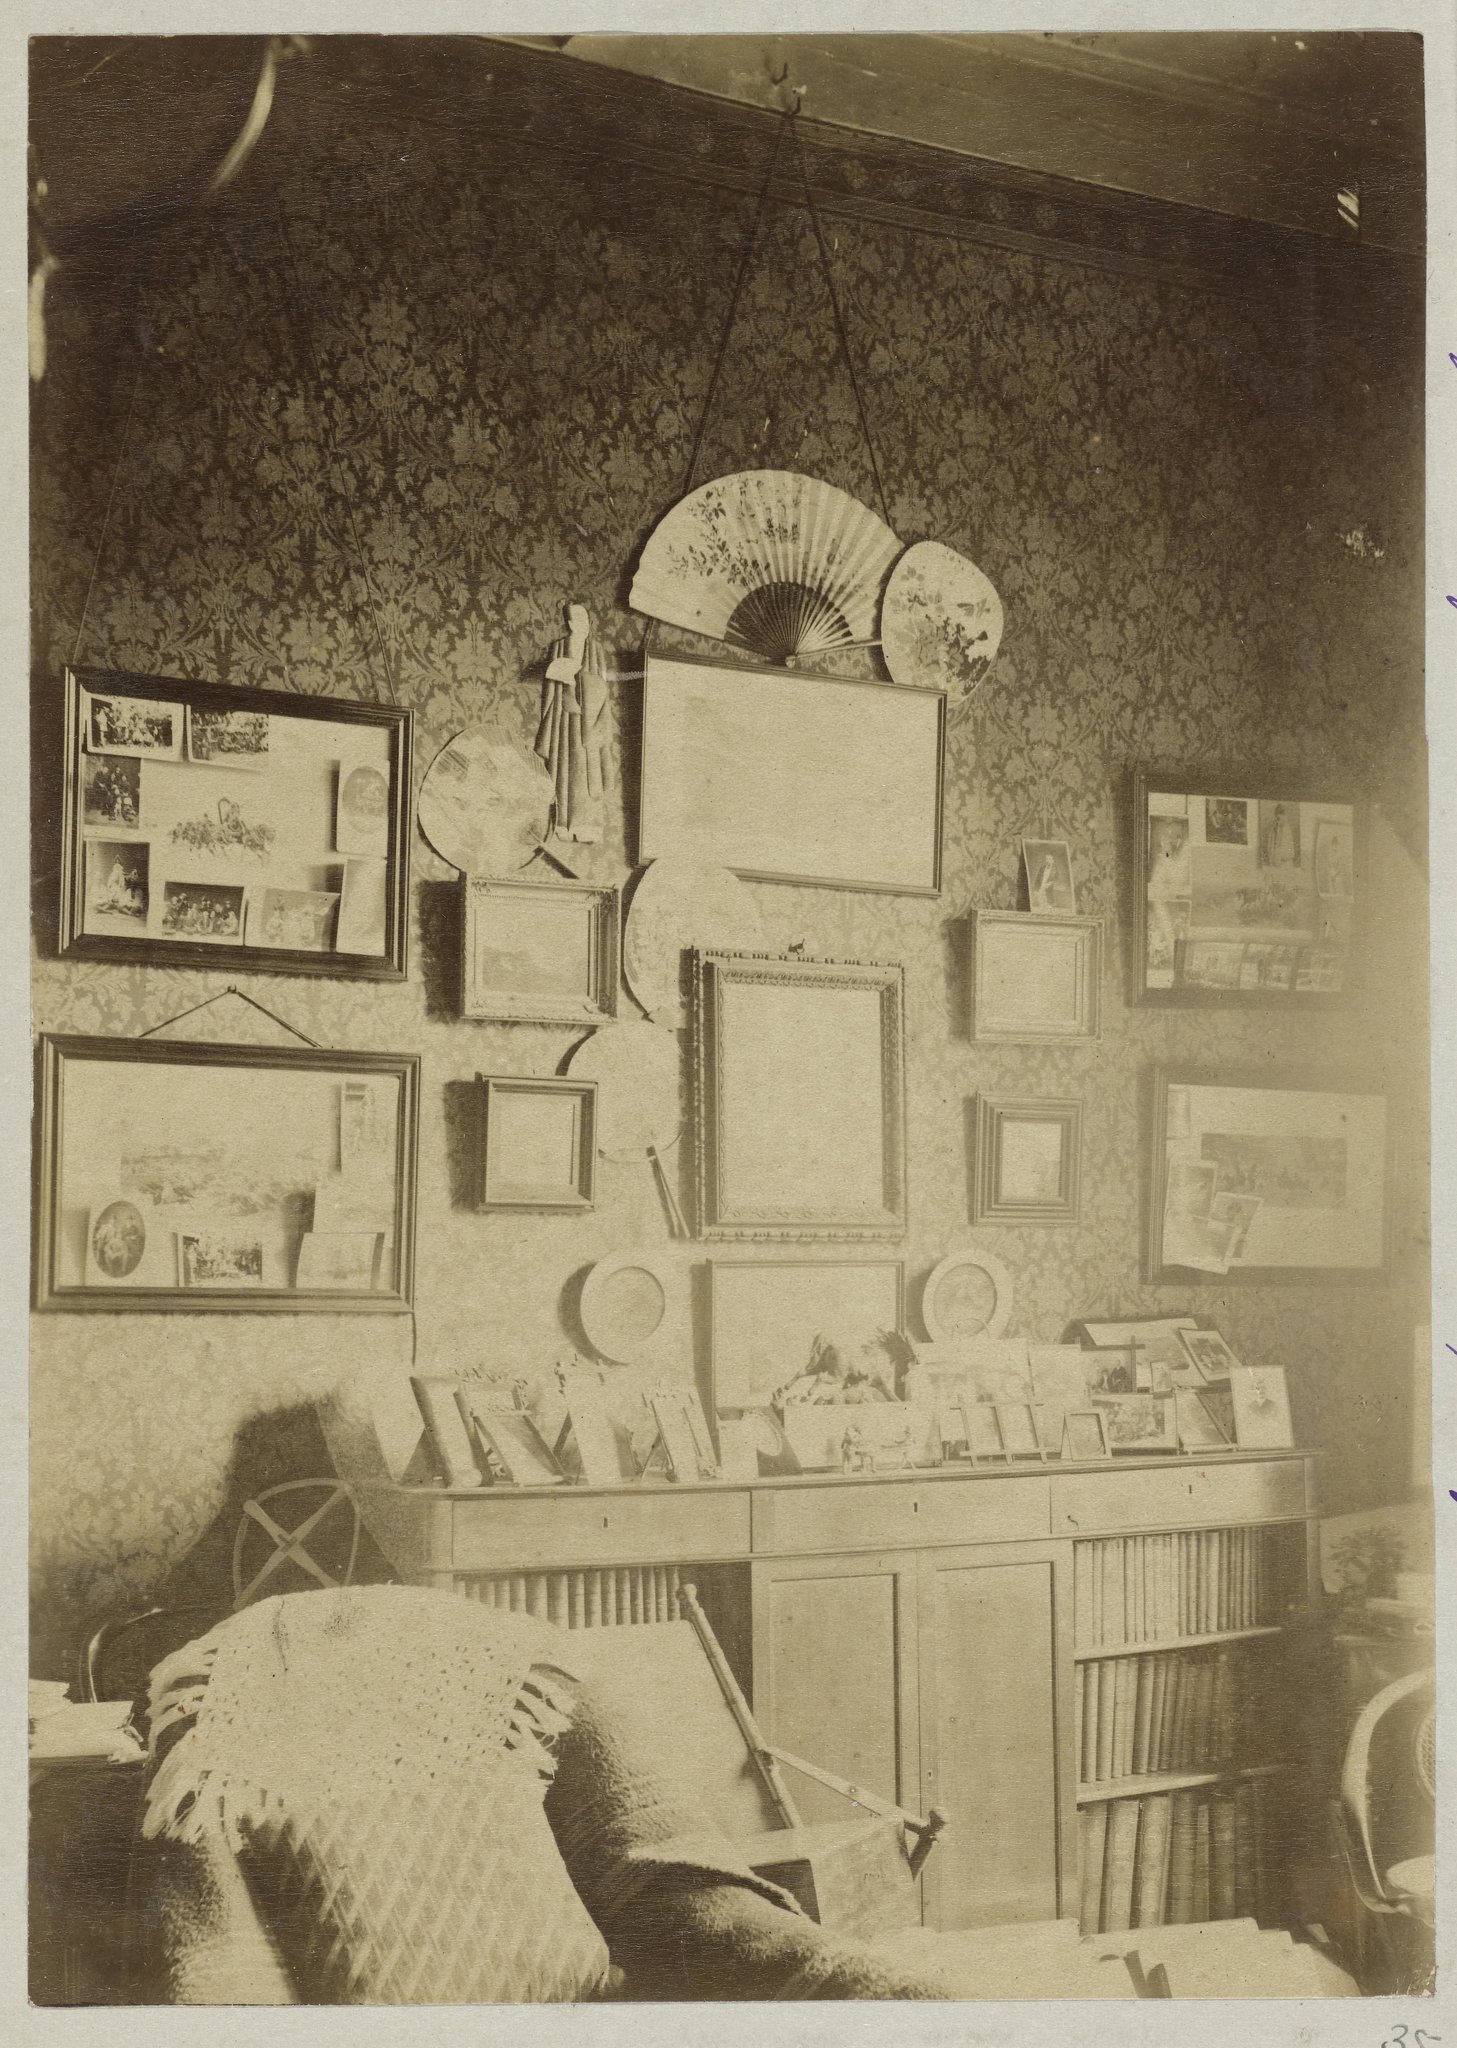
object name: photograph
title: Kamer van J.W des Tombe aan de Plompetorengracht 1-3 in Utrecht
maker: henry pauw van wieldrecht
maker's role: fotograaf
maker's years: 1863-1912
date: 1888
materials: paper, photographic support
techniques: albumen print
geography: netherlands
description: Een kamer met behang en vele foto's en afbeeldingen aan de wand. Op de grond een boekenkast met daarop fotolijstjes. Links op het albumblad geschreven: Kamer v. des Tombe. Plompetoren Utrecht.